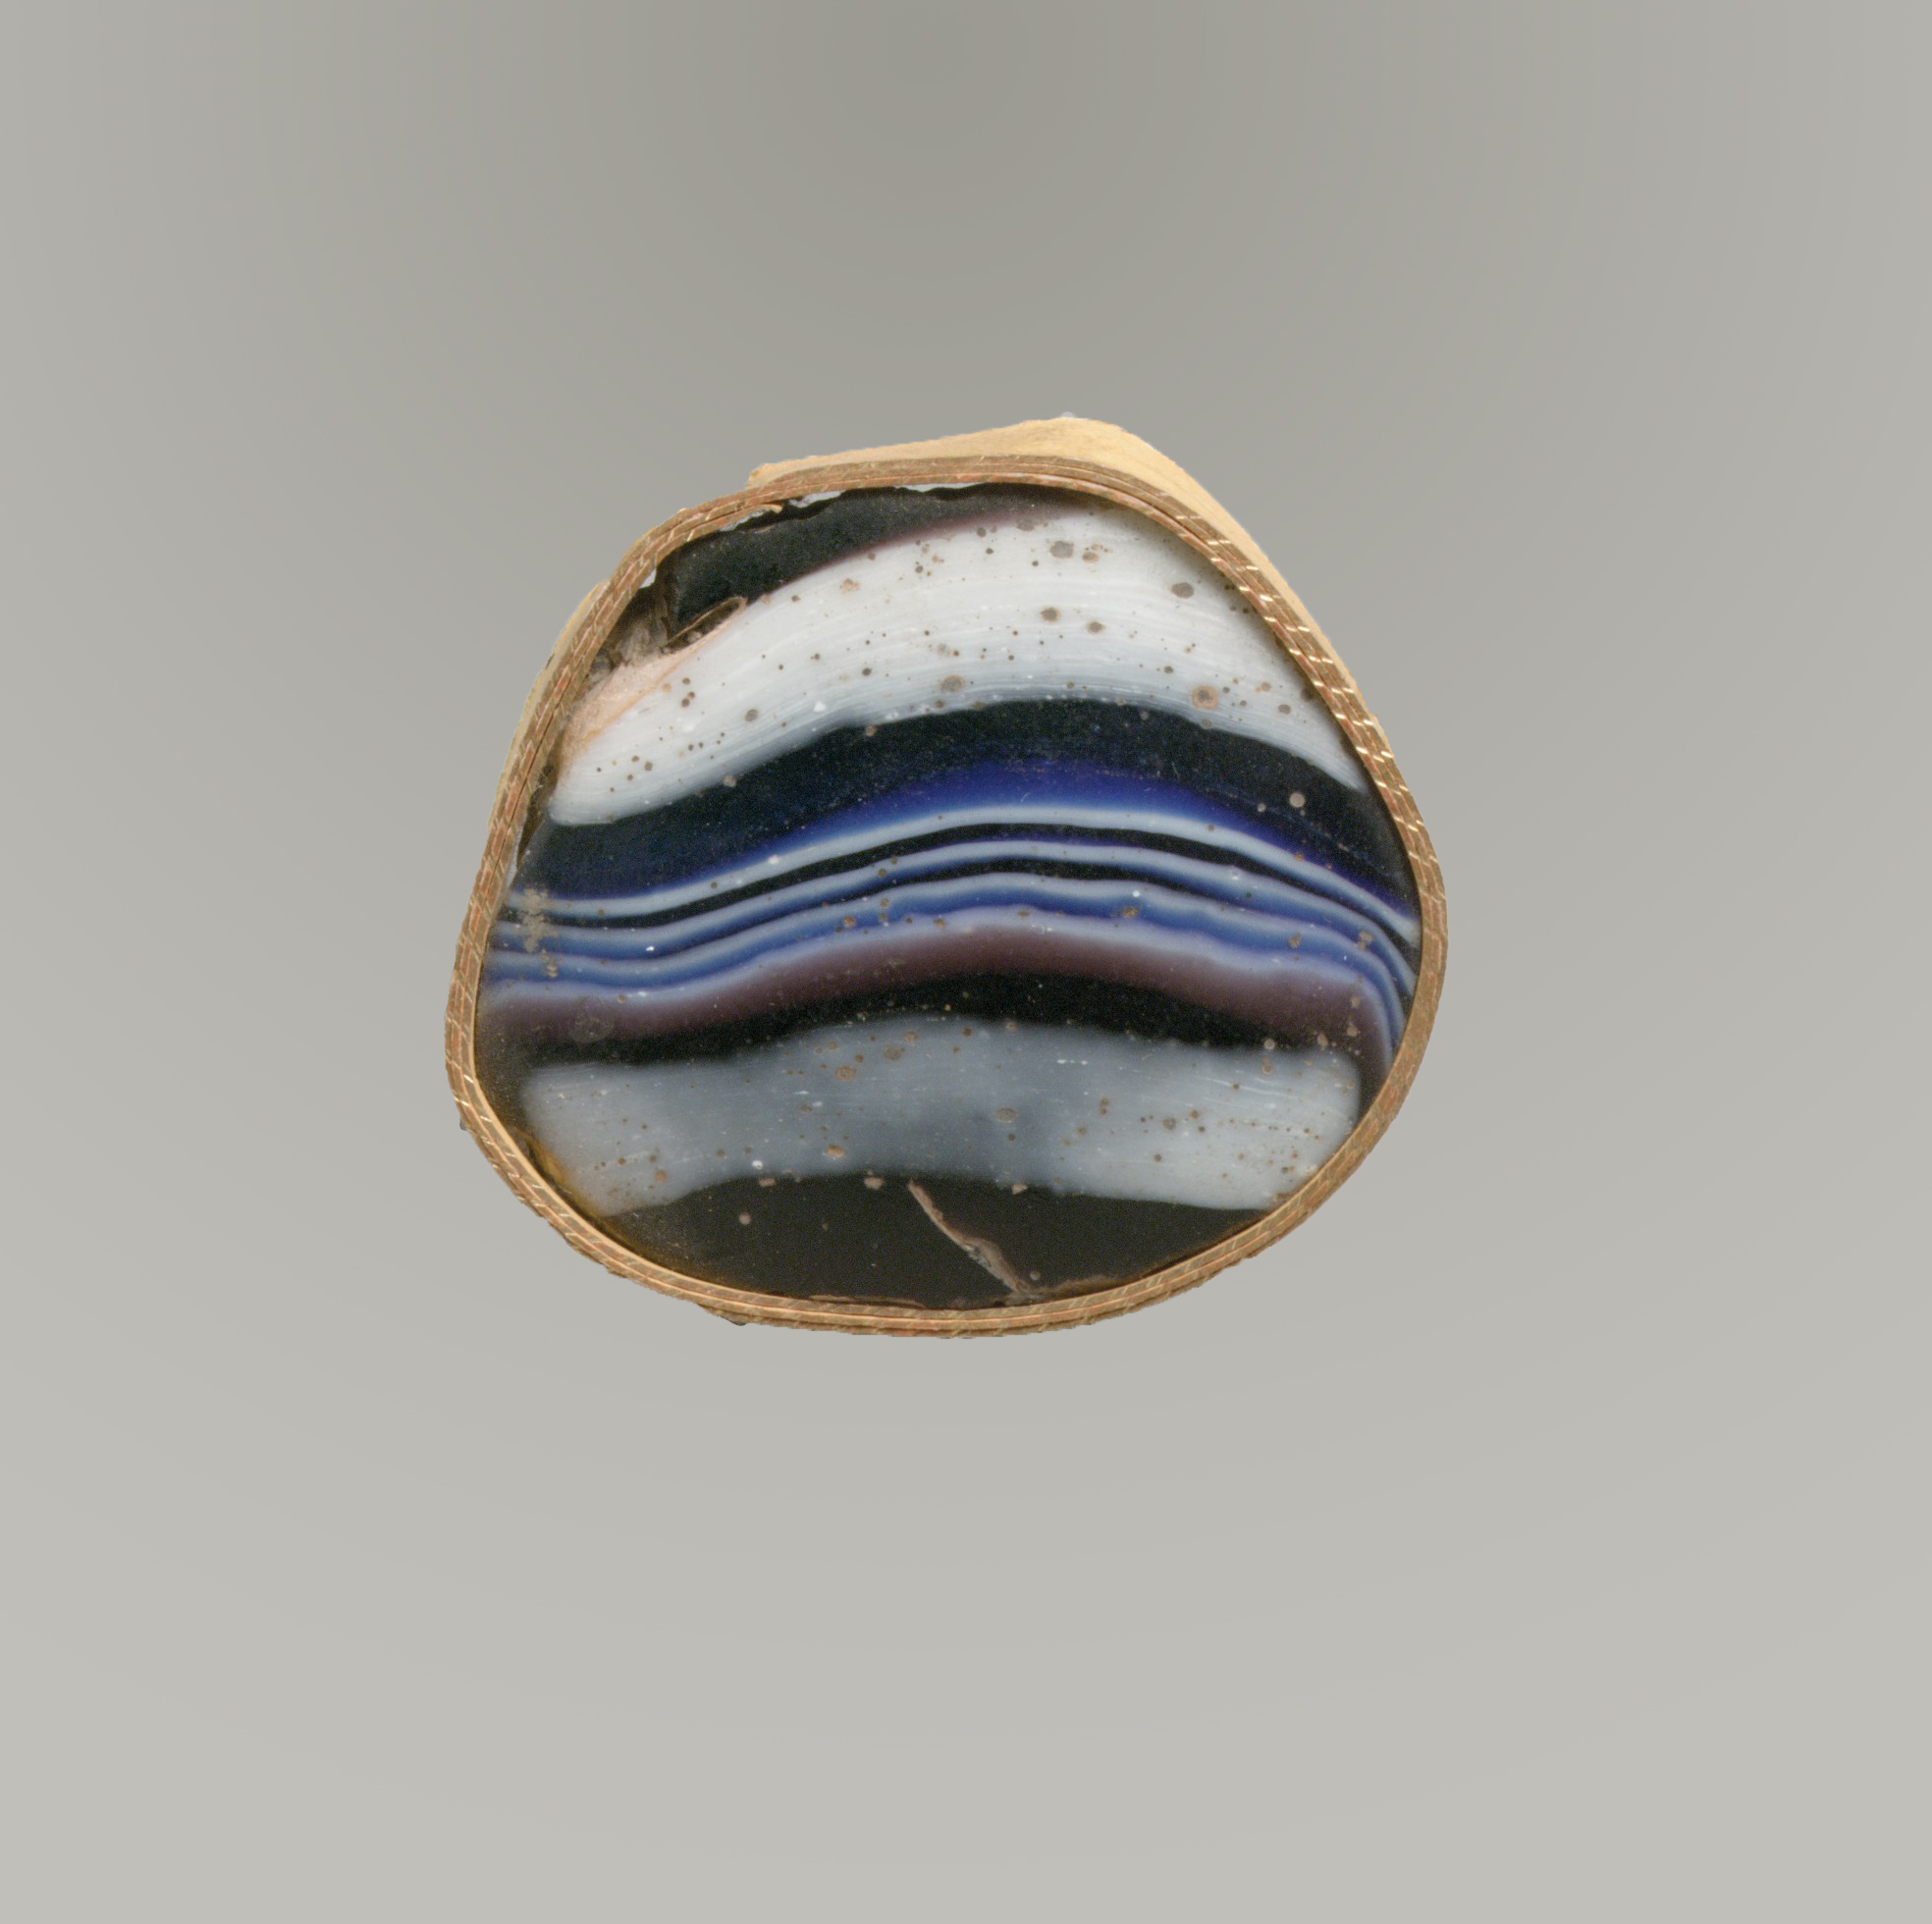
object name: fragment, mosaic base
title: Glass mosaic fragment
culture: roman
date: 34 BCE-33 CE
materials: glass